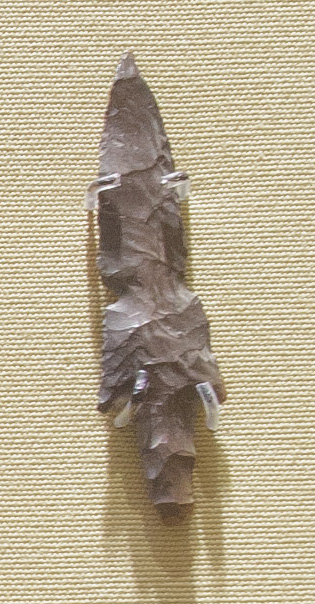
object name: arrowhead, projectile point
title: Arrowhead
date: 5000-3900 BCE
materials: stone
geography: egypt